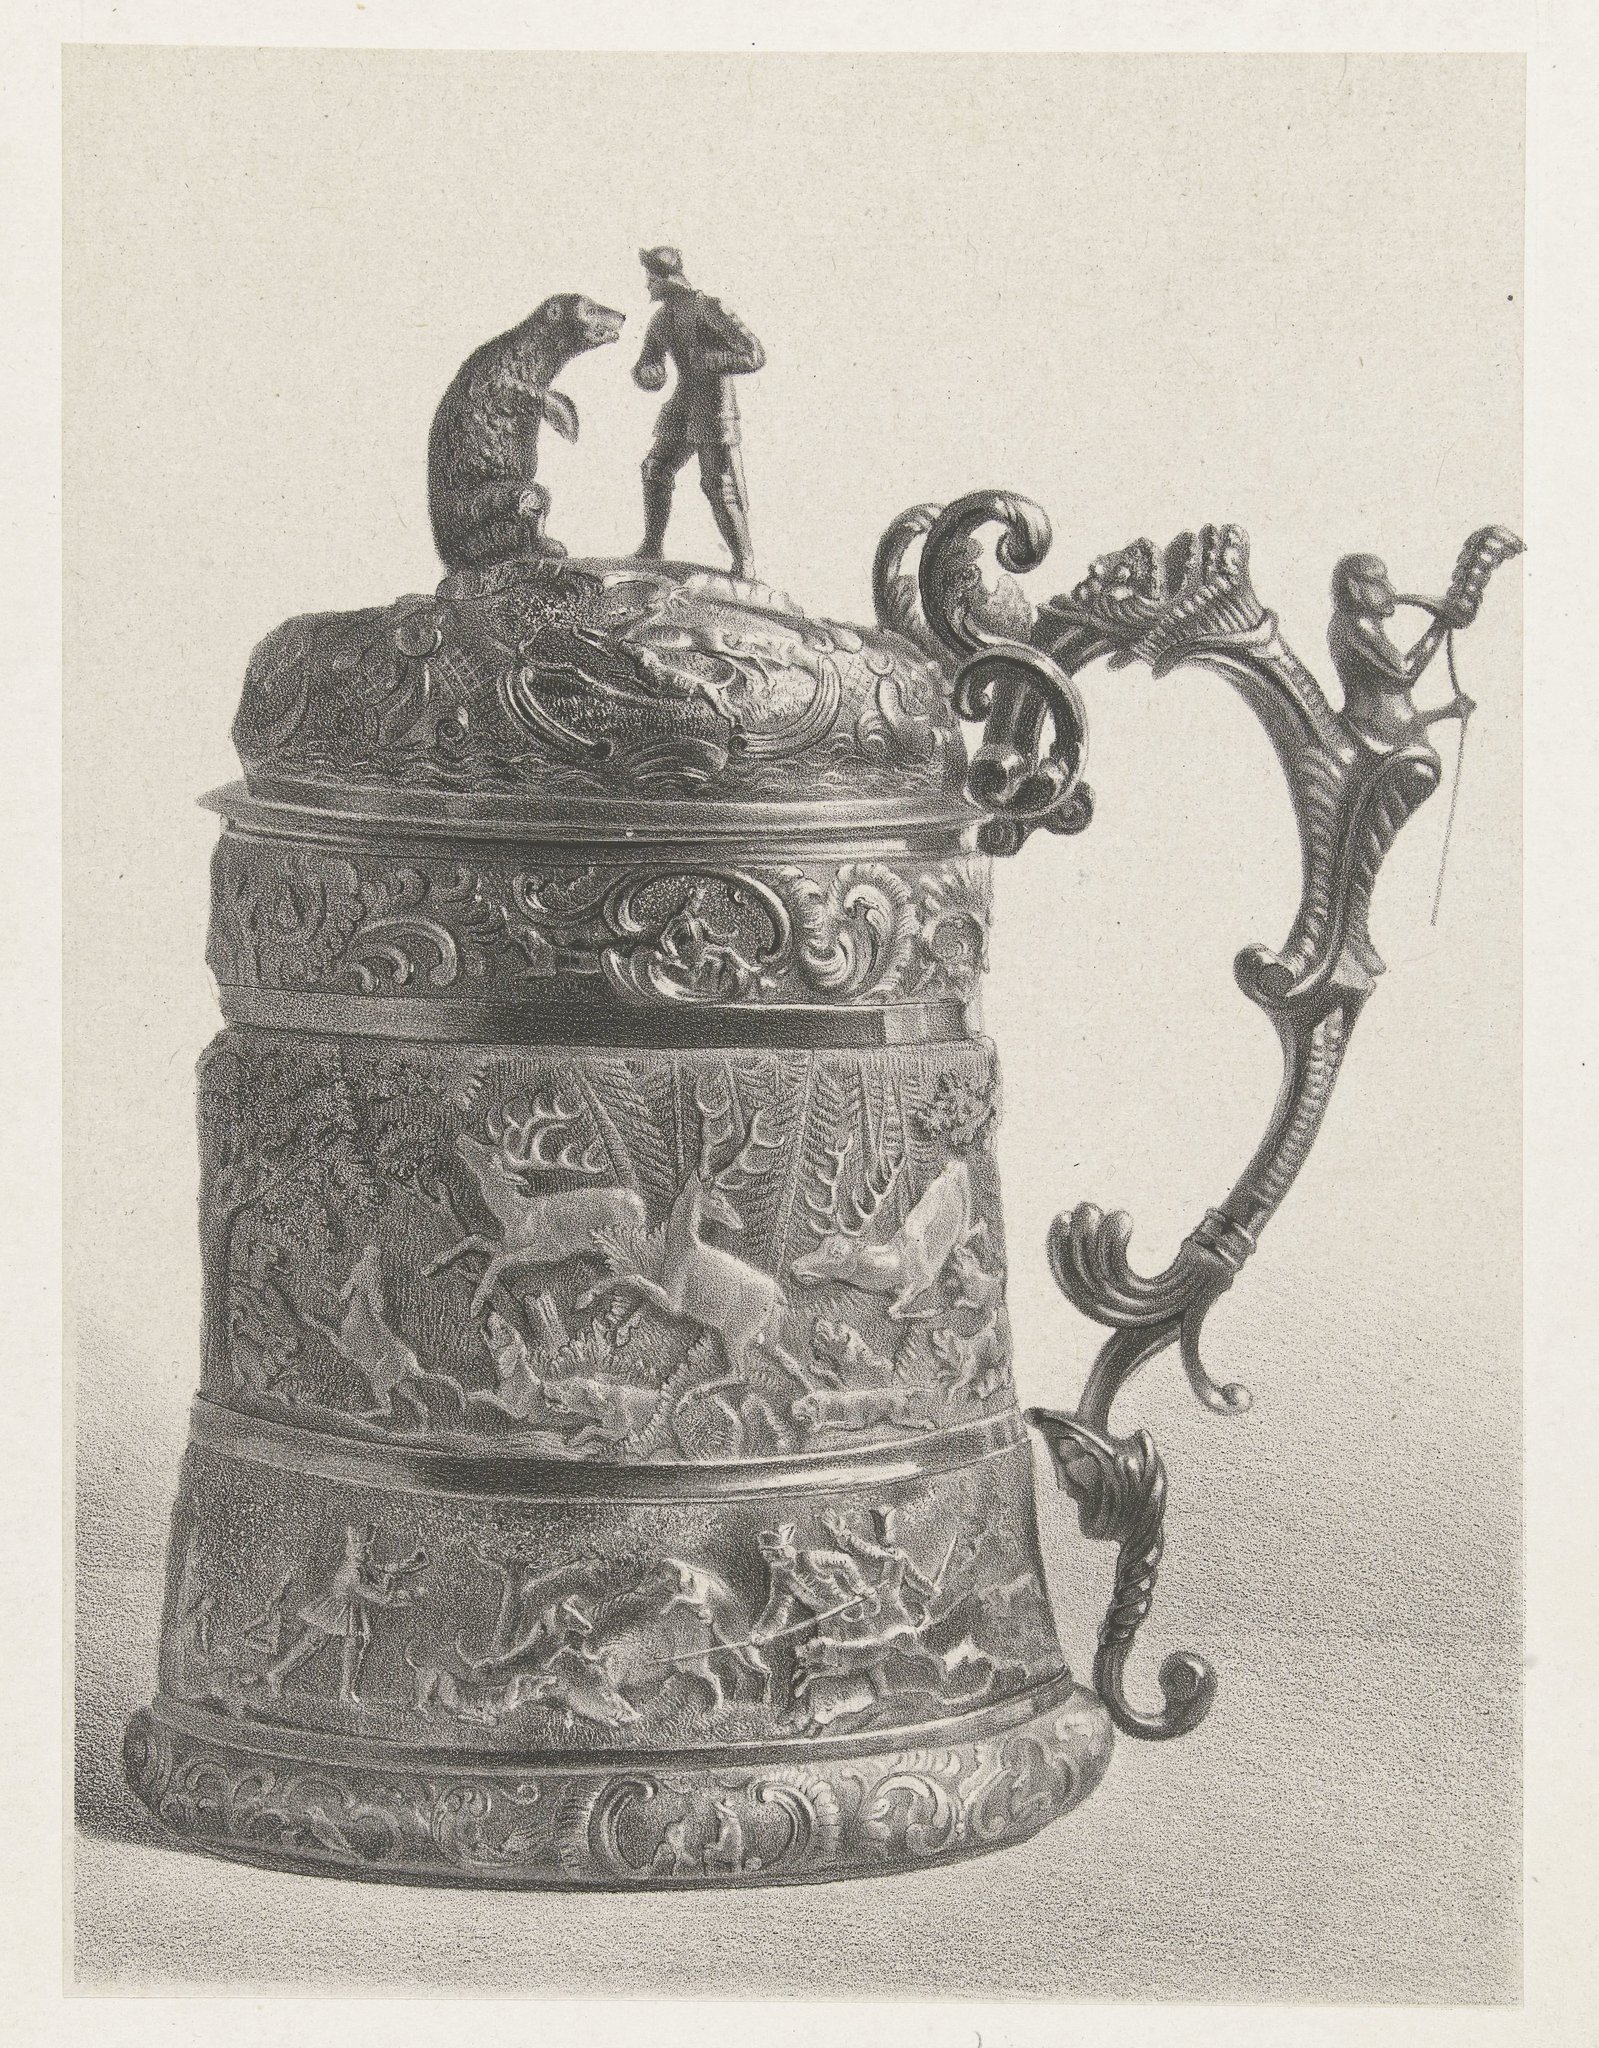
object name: print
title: Drinkkan versierd met jachtscènes, ca. 1700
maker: Anonymous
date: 1800-1863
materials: paper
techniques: tone lithography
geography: netherlands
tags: mug, beaker, goblet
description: Drinkkan of -beker met handvat en deksel, versierd met jachtscènes. Op de deksel een man en een beer.